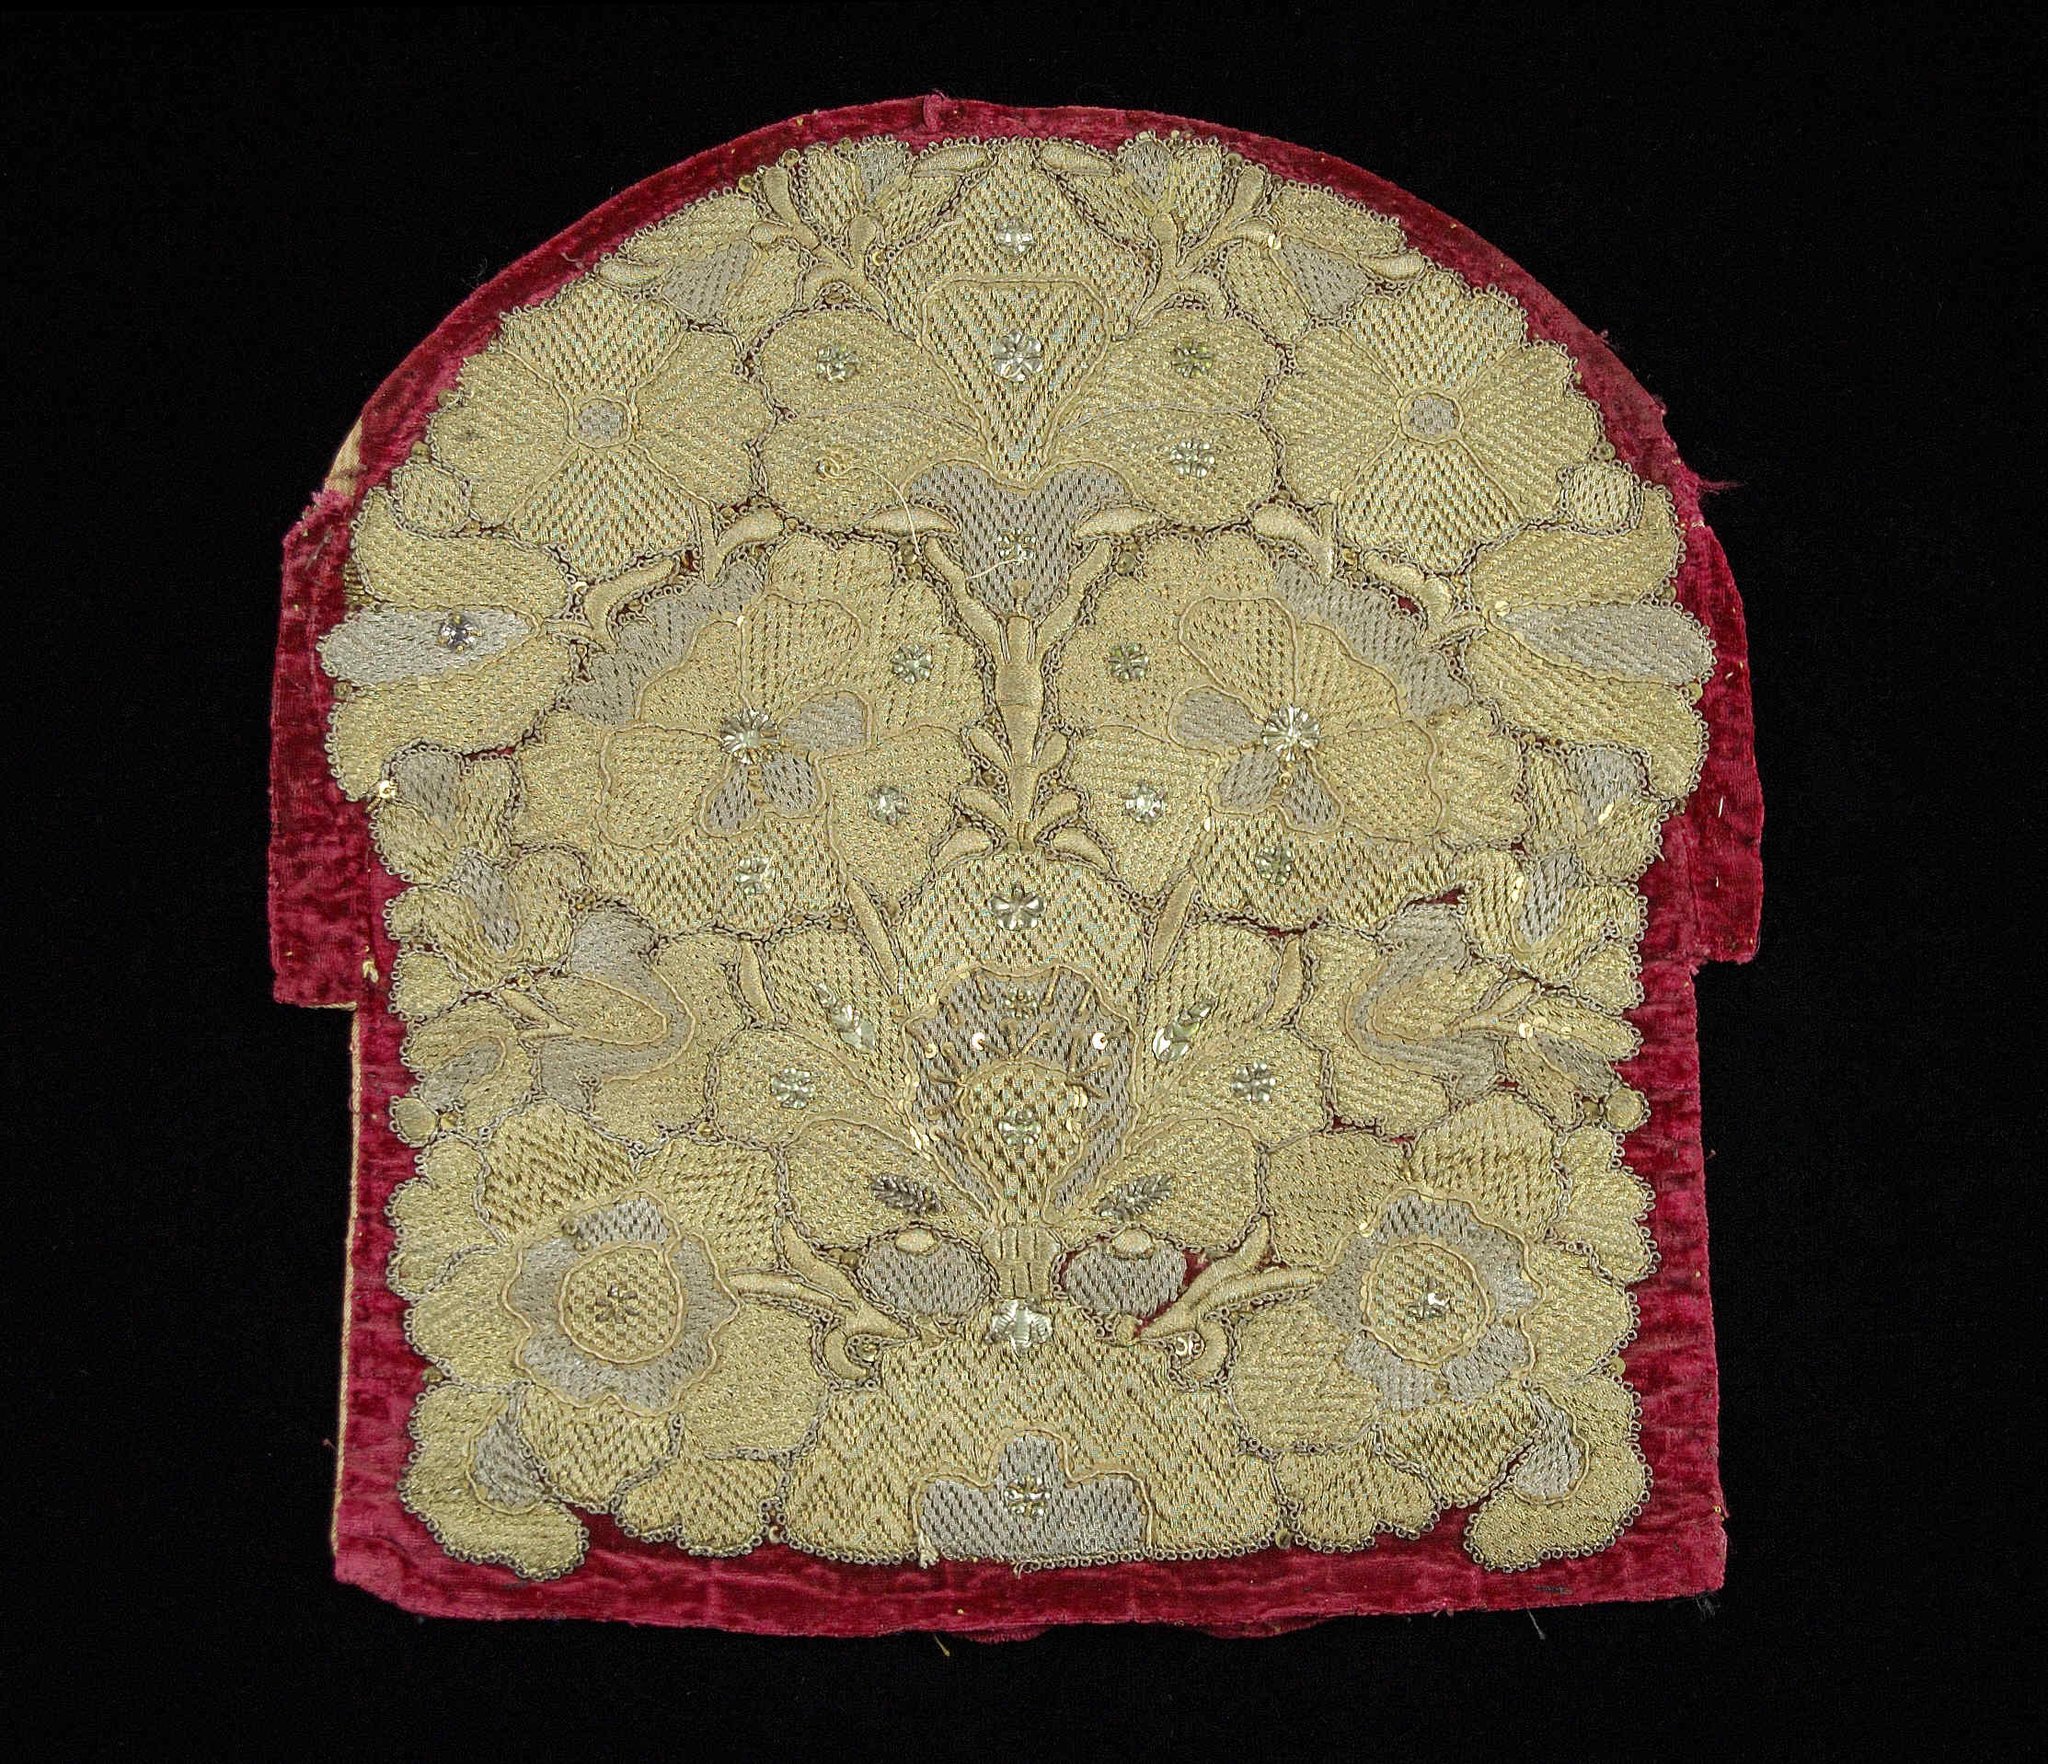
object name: headdress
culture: russian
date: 1850-1899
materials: linen, metal, silk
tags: flowers